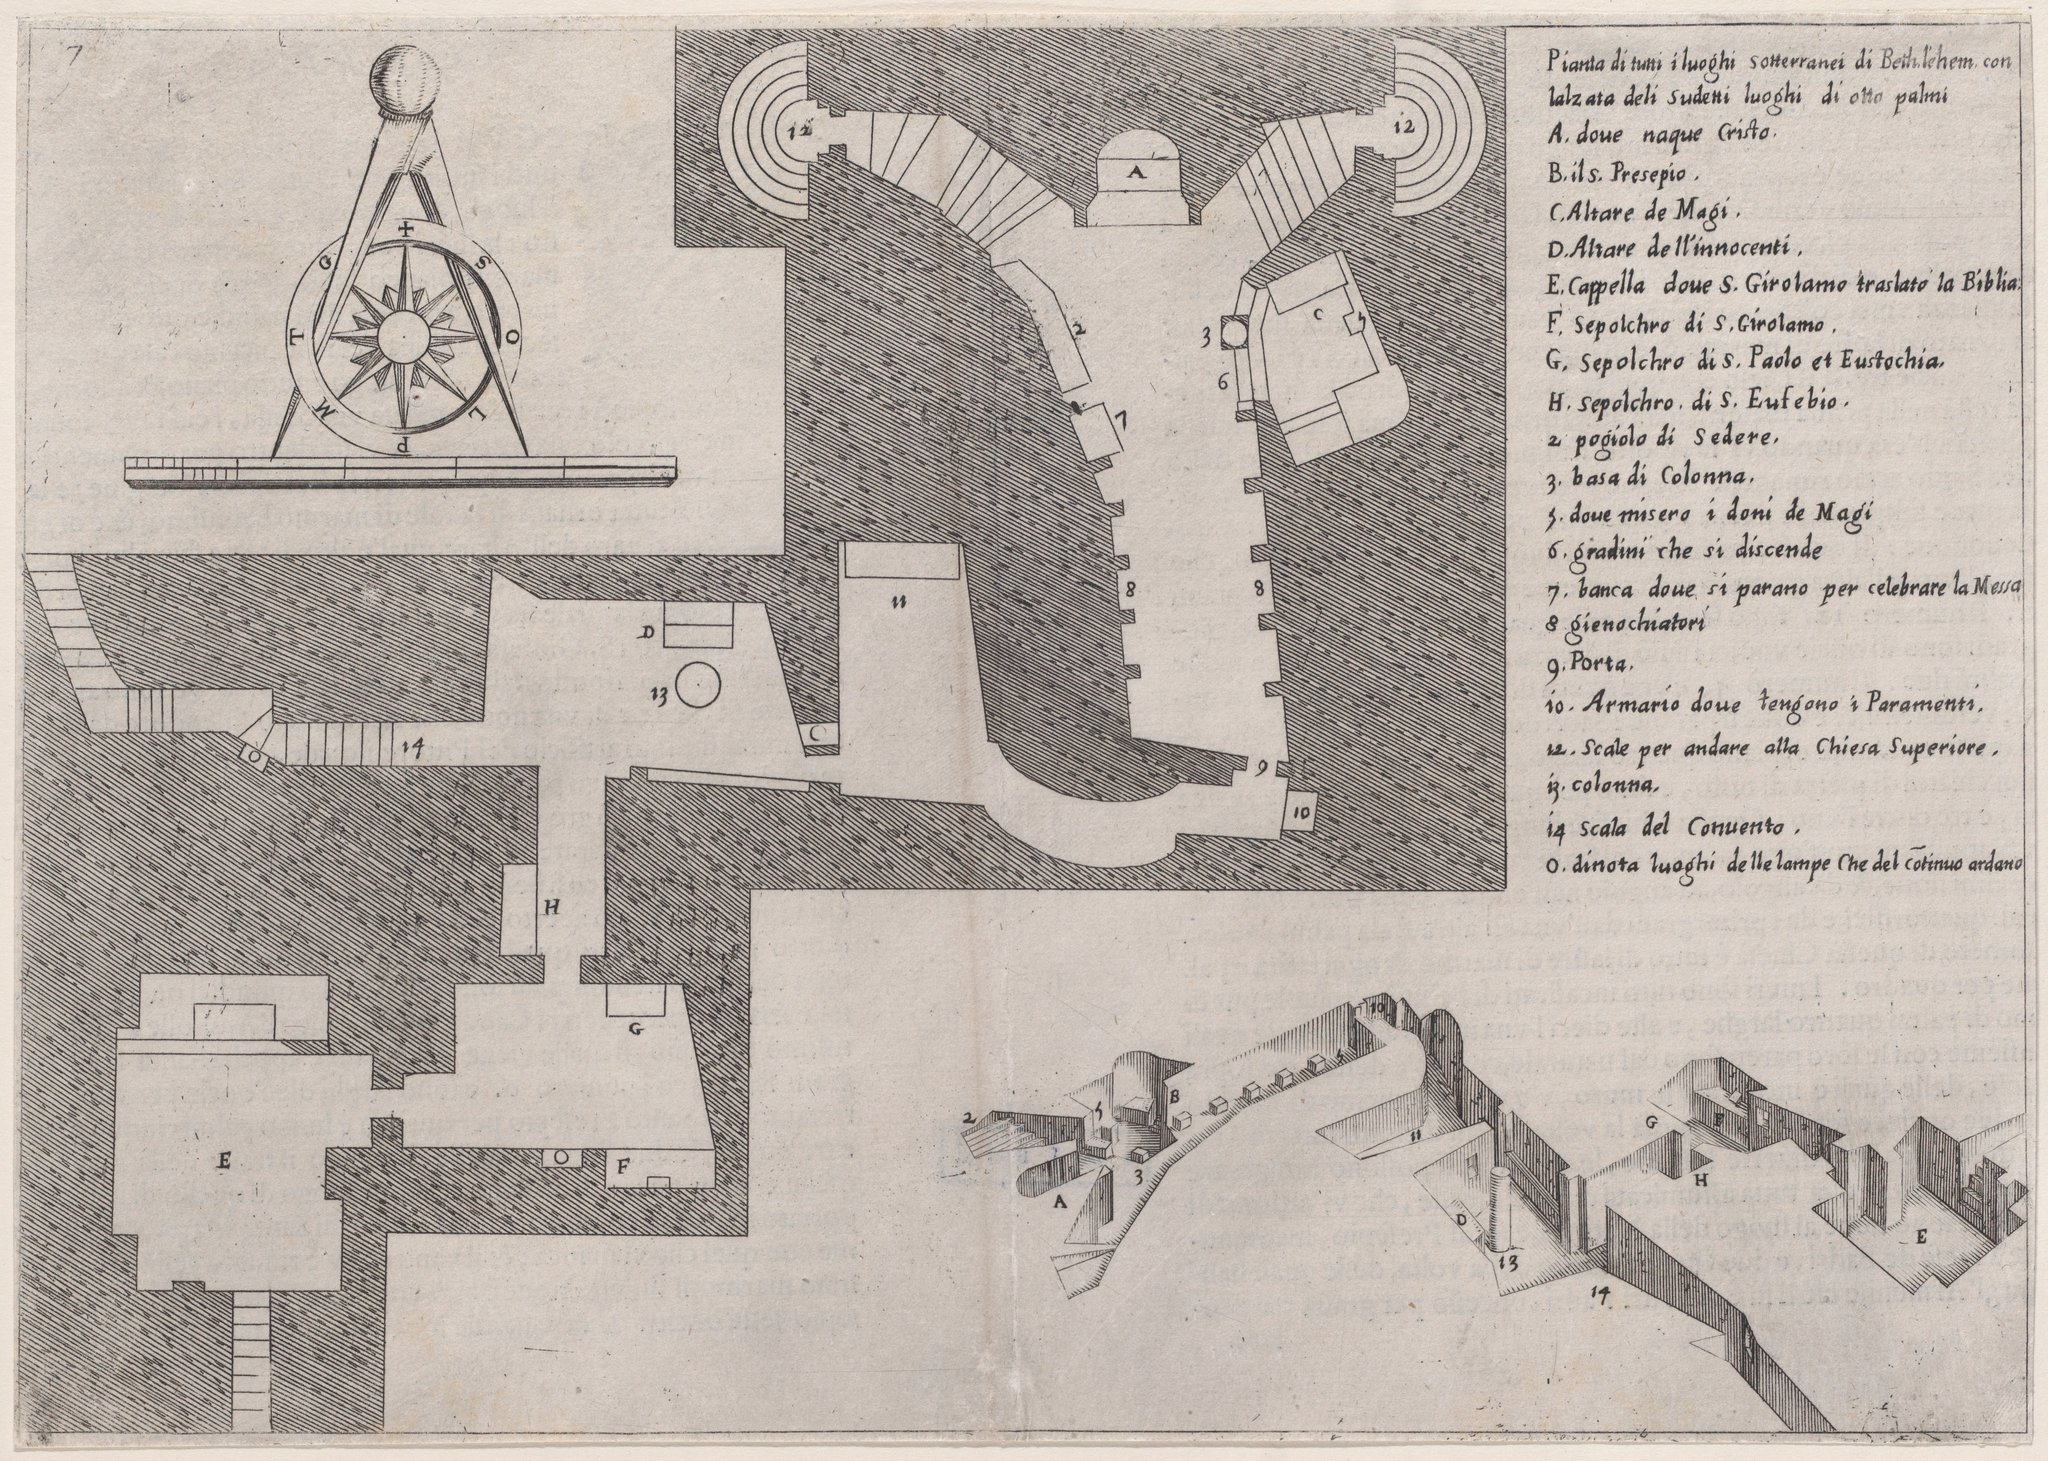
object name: print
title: Plate 6, from "Trattato delle Piante & Immagini de Sacri Edifizi di Terra Santa" (Treatise of the Plans & Images of the Sacred Buildings of the Holy Land)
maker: jacques callot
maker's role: artist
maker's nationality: french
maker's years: 1592-1635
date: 1620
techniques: engraving, etching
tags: architecture,buildings